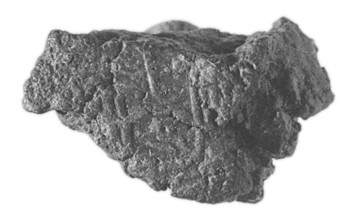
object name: sealing fragment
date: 2030-1640 BCE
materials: clay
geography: egypt